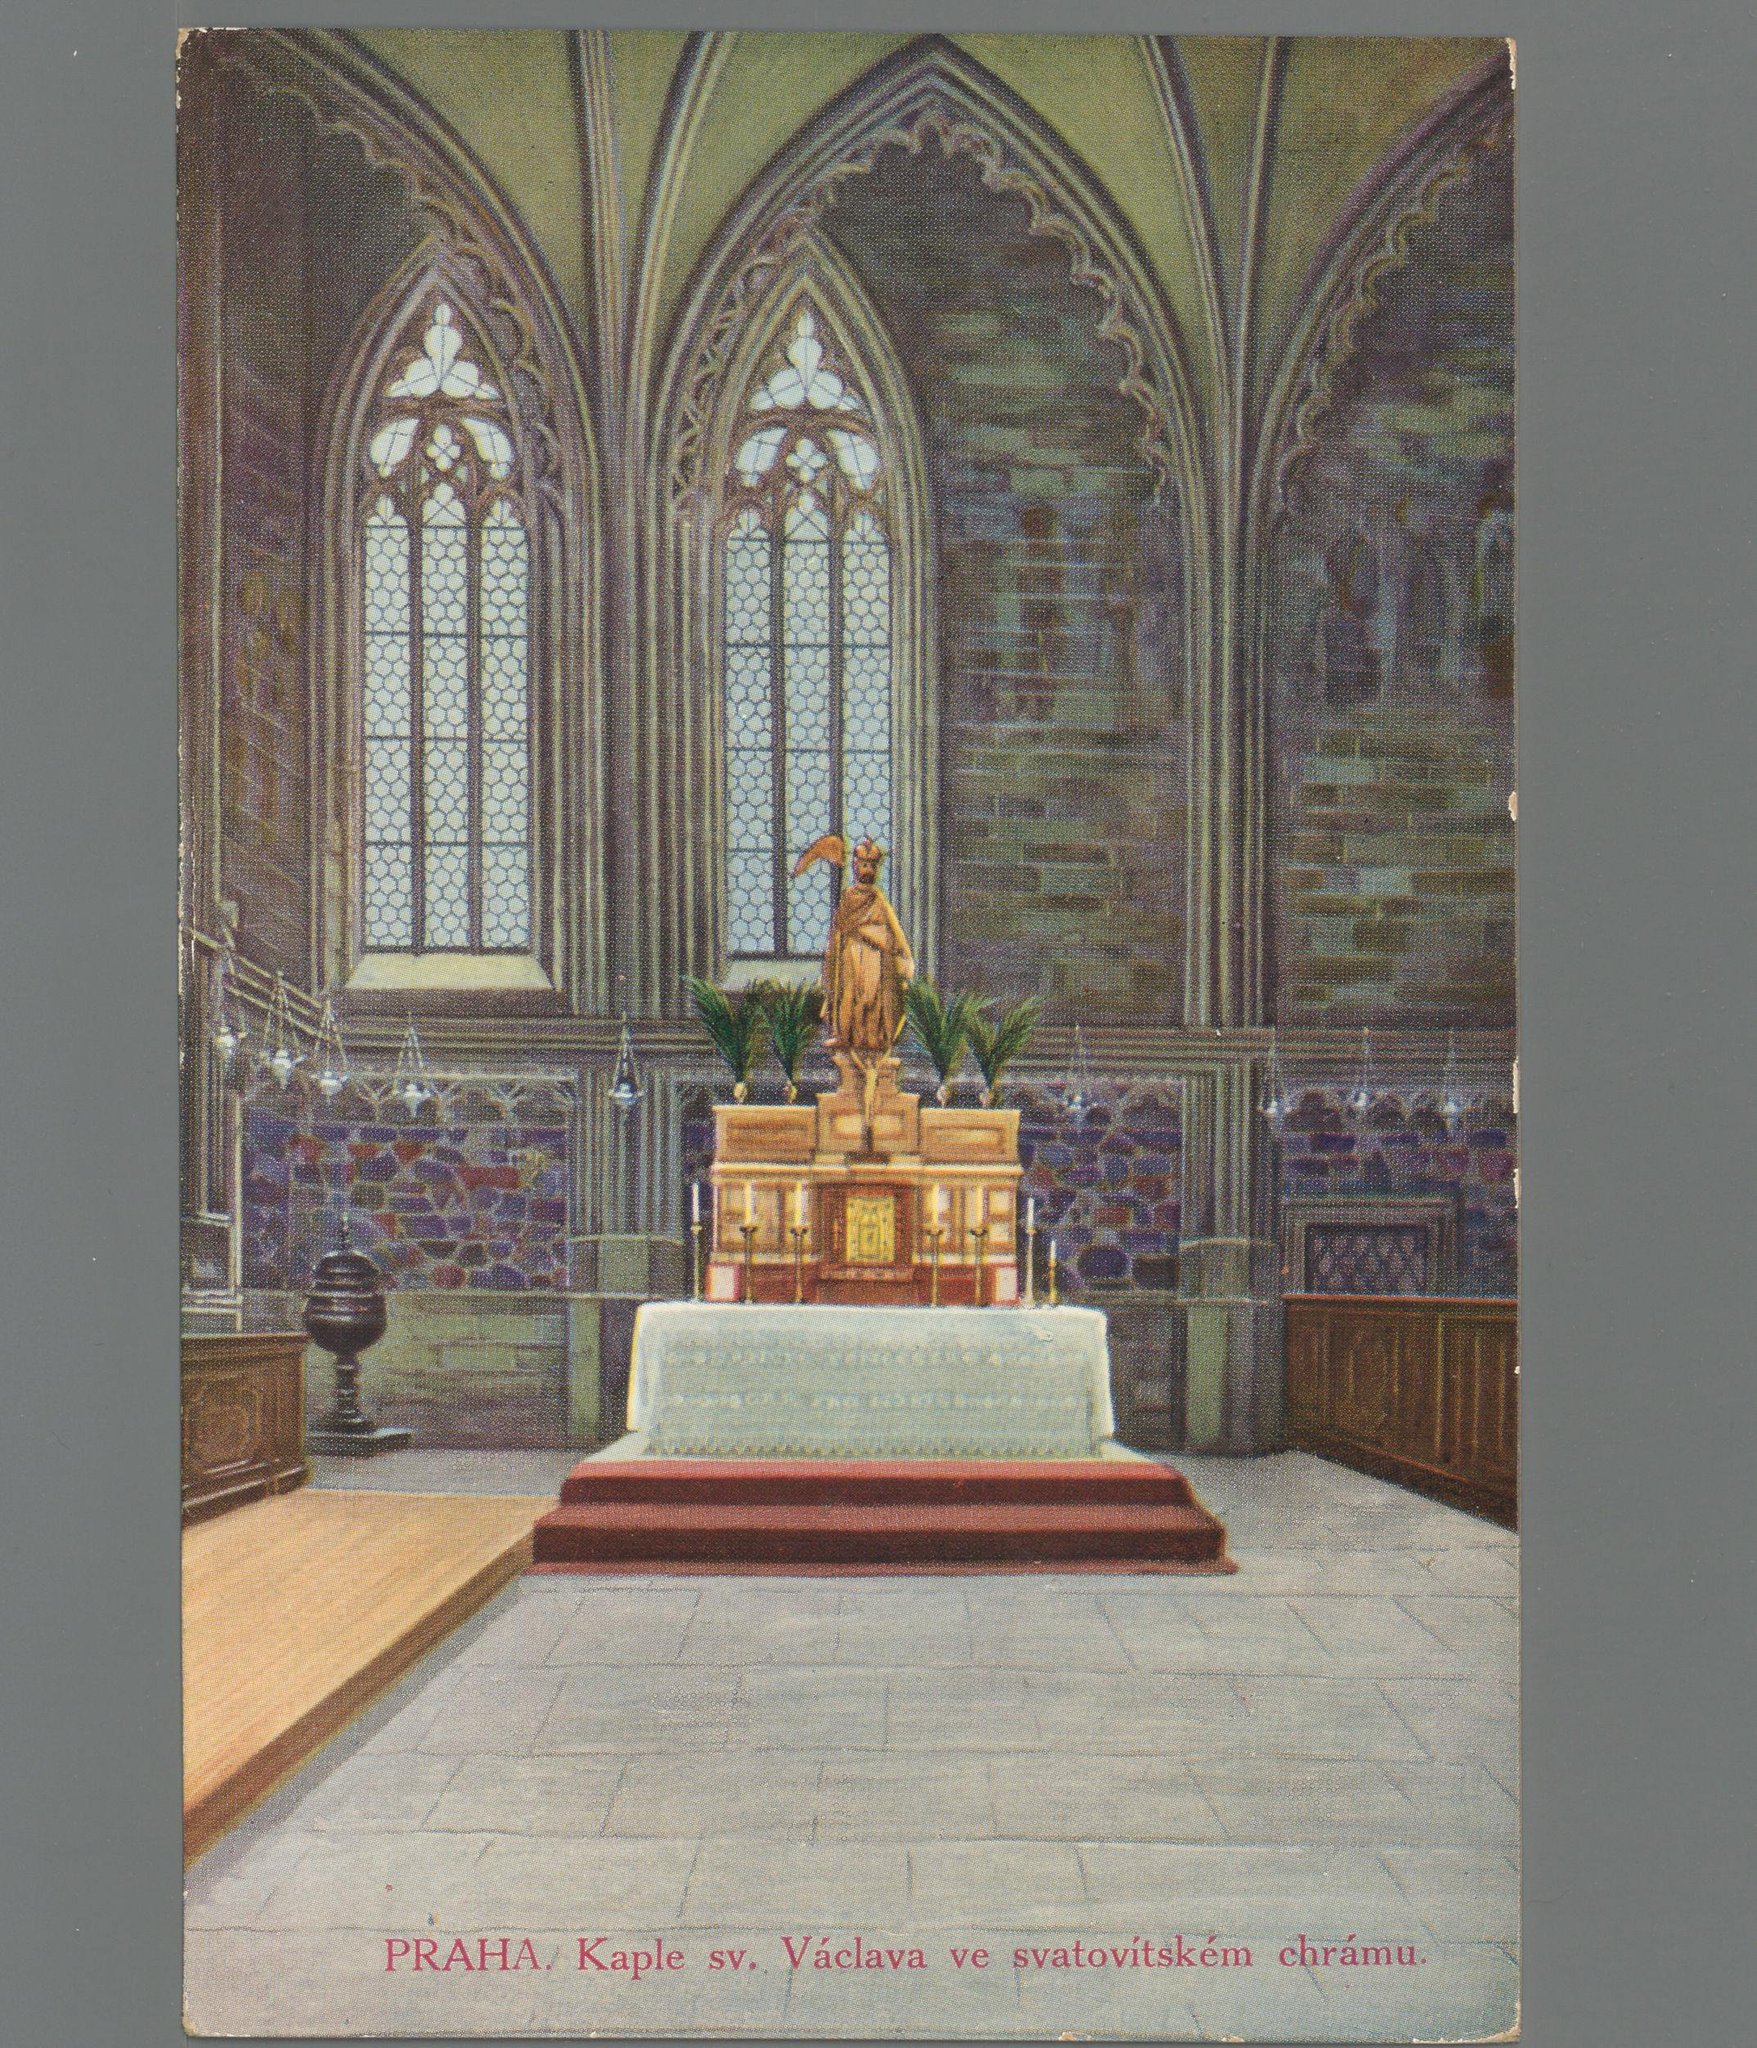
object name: ansichtkaart, prentbriefkaart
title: Praha. Kaple sv. Václava ve svatovítském chrámu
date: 1906-1930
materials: cardboard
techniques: color autotype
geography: prague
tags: interior of church, parts of church interior: chapel